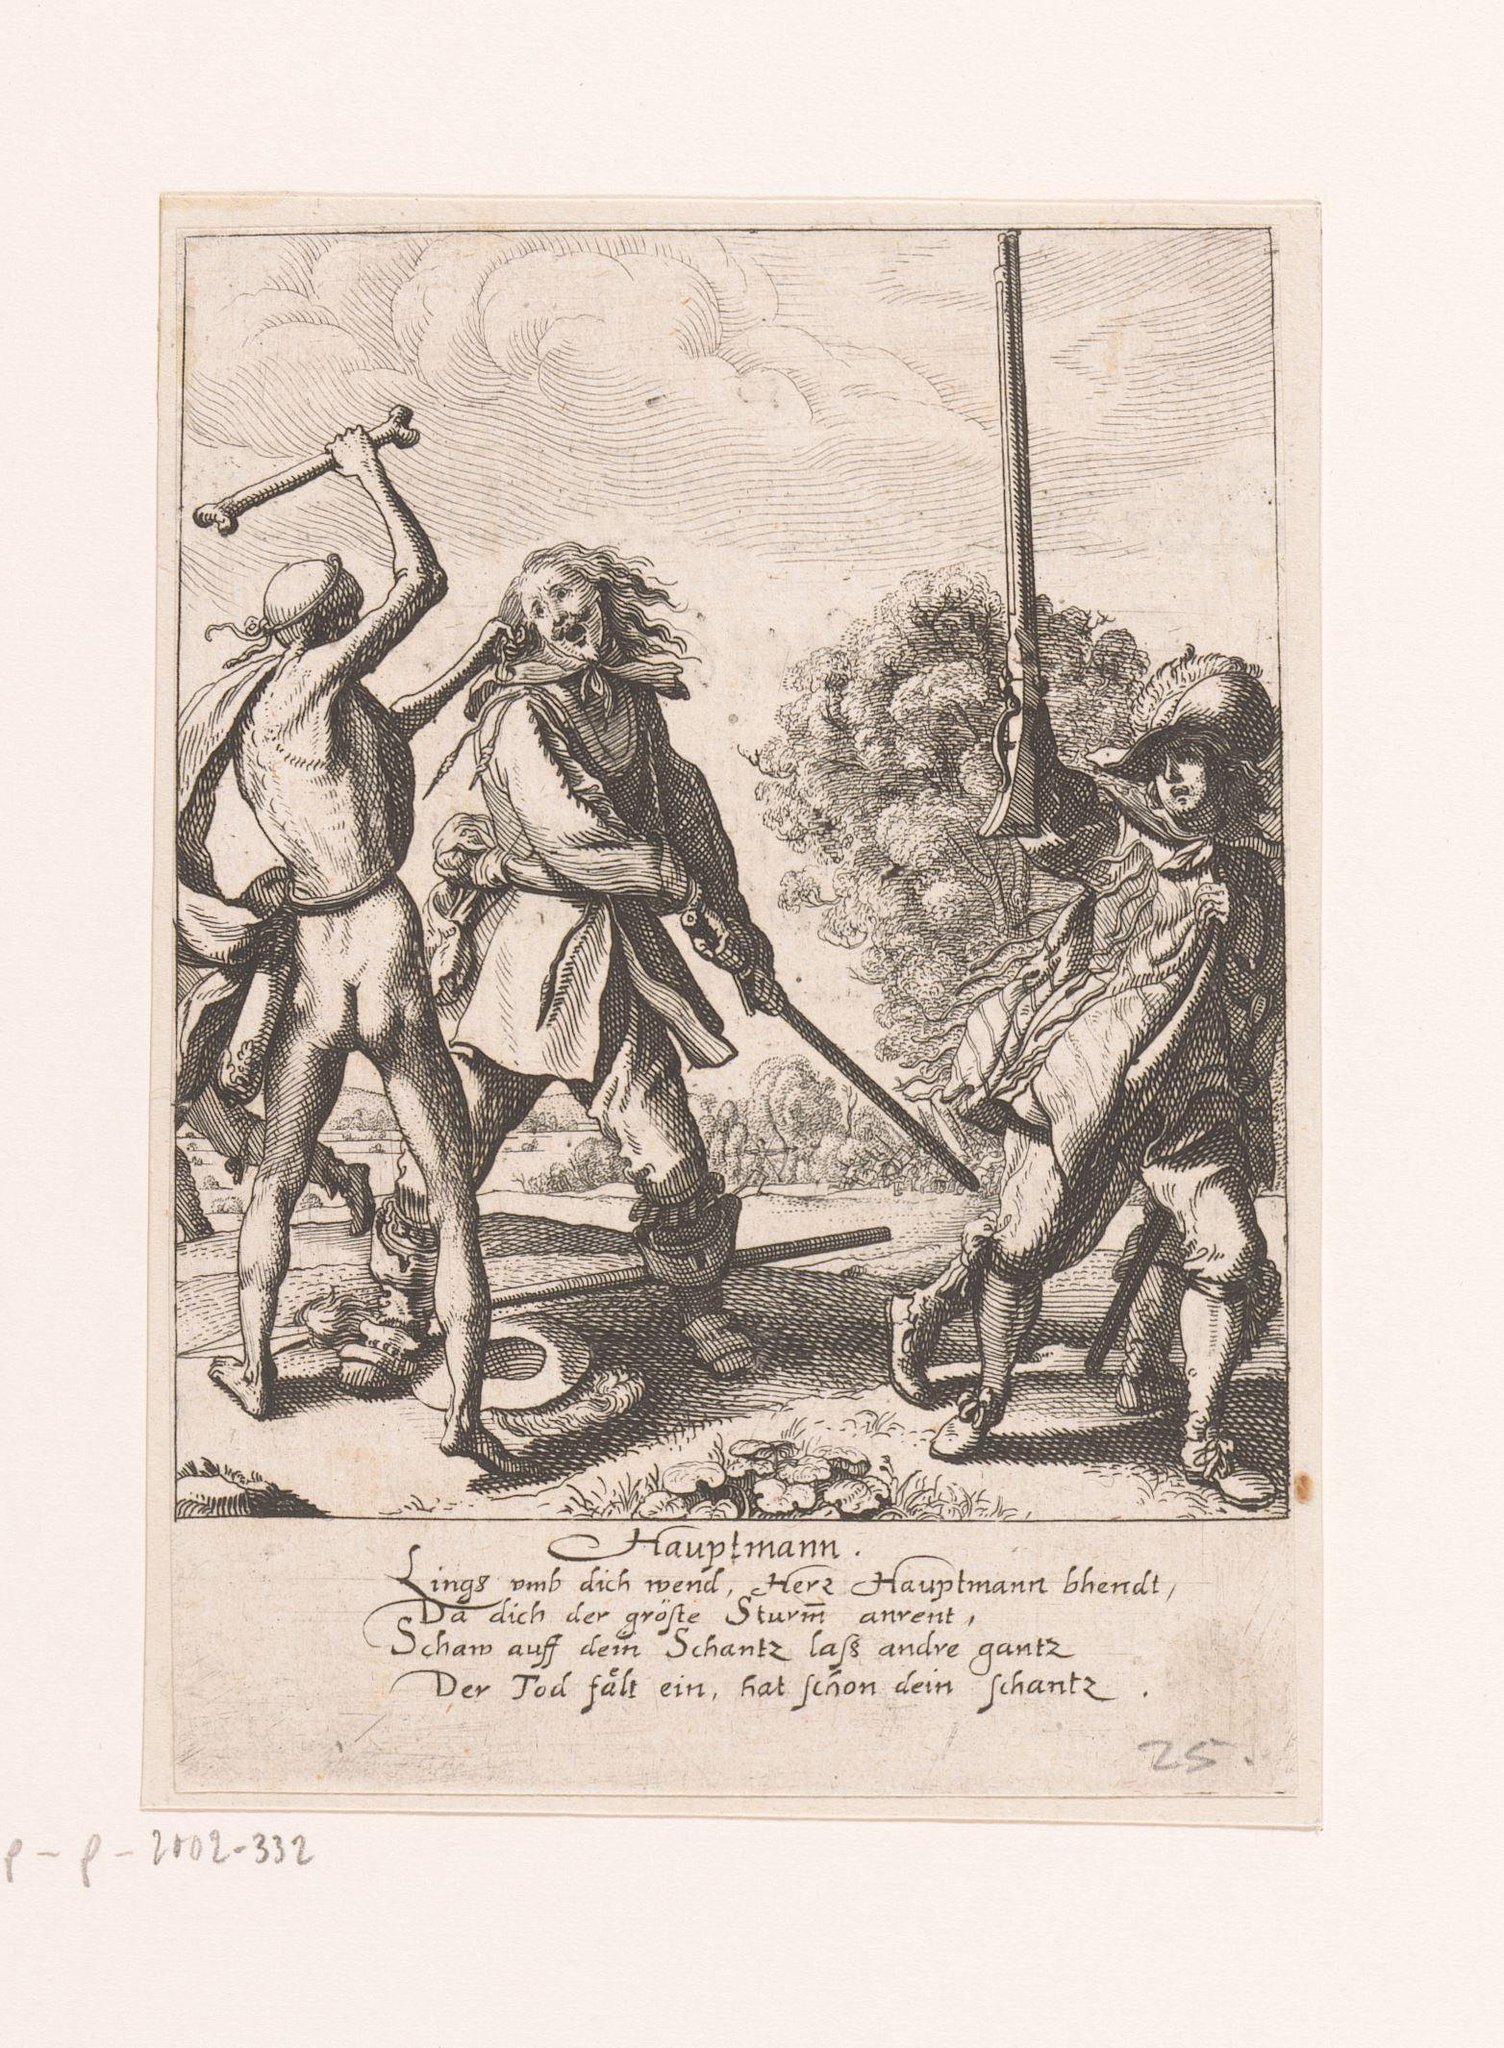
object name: book illustration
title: Hauptmann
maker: johann jakob bodmer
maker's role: printer, publisher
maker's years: 1629-1650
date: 1650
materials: paper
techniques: etching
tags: personifications of death; 'morte' (ripa), dance of death; death together with one or more human beings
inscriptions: collector's mark: Lugt 2228, collector's mark: Lugt 2233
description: Prent uit: Meyer, Rudolph. Sterbenspiegel, das ist sonnenklare Vorstellung menschlicher Nichtigkeit durch alle Ständ und Geschlechter (...). Zürich: J.J. Bodmer, 1650.